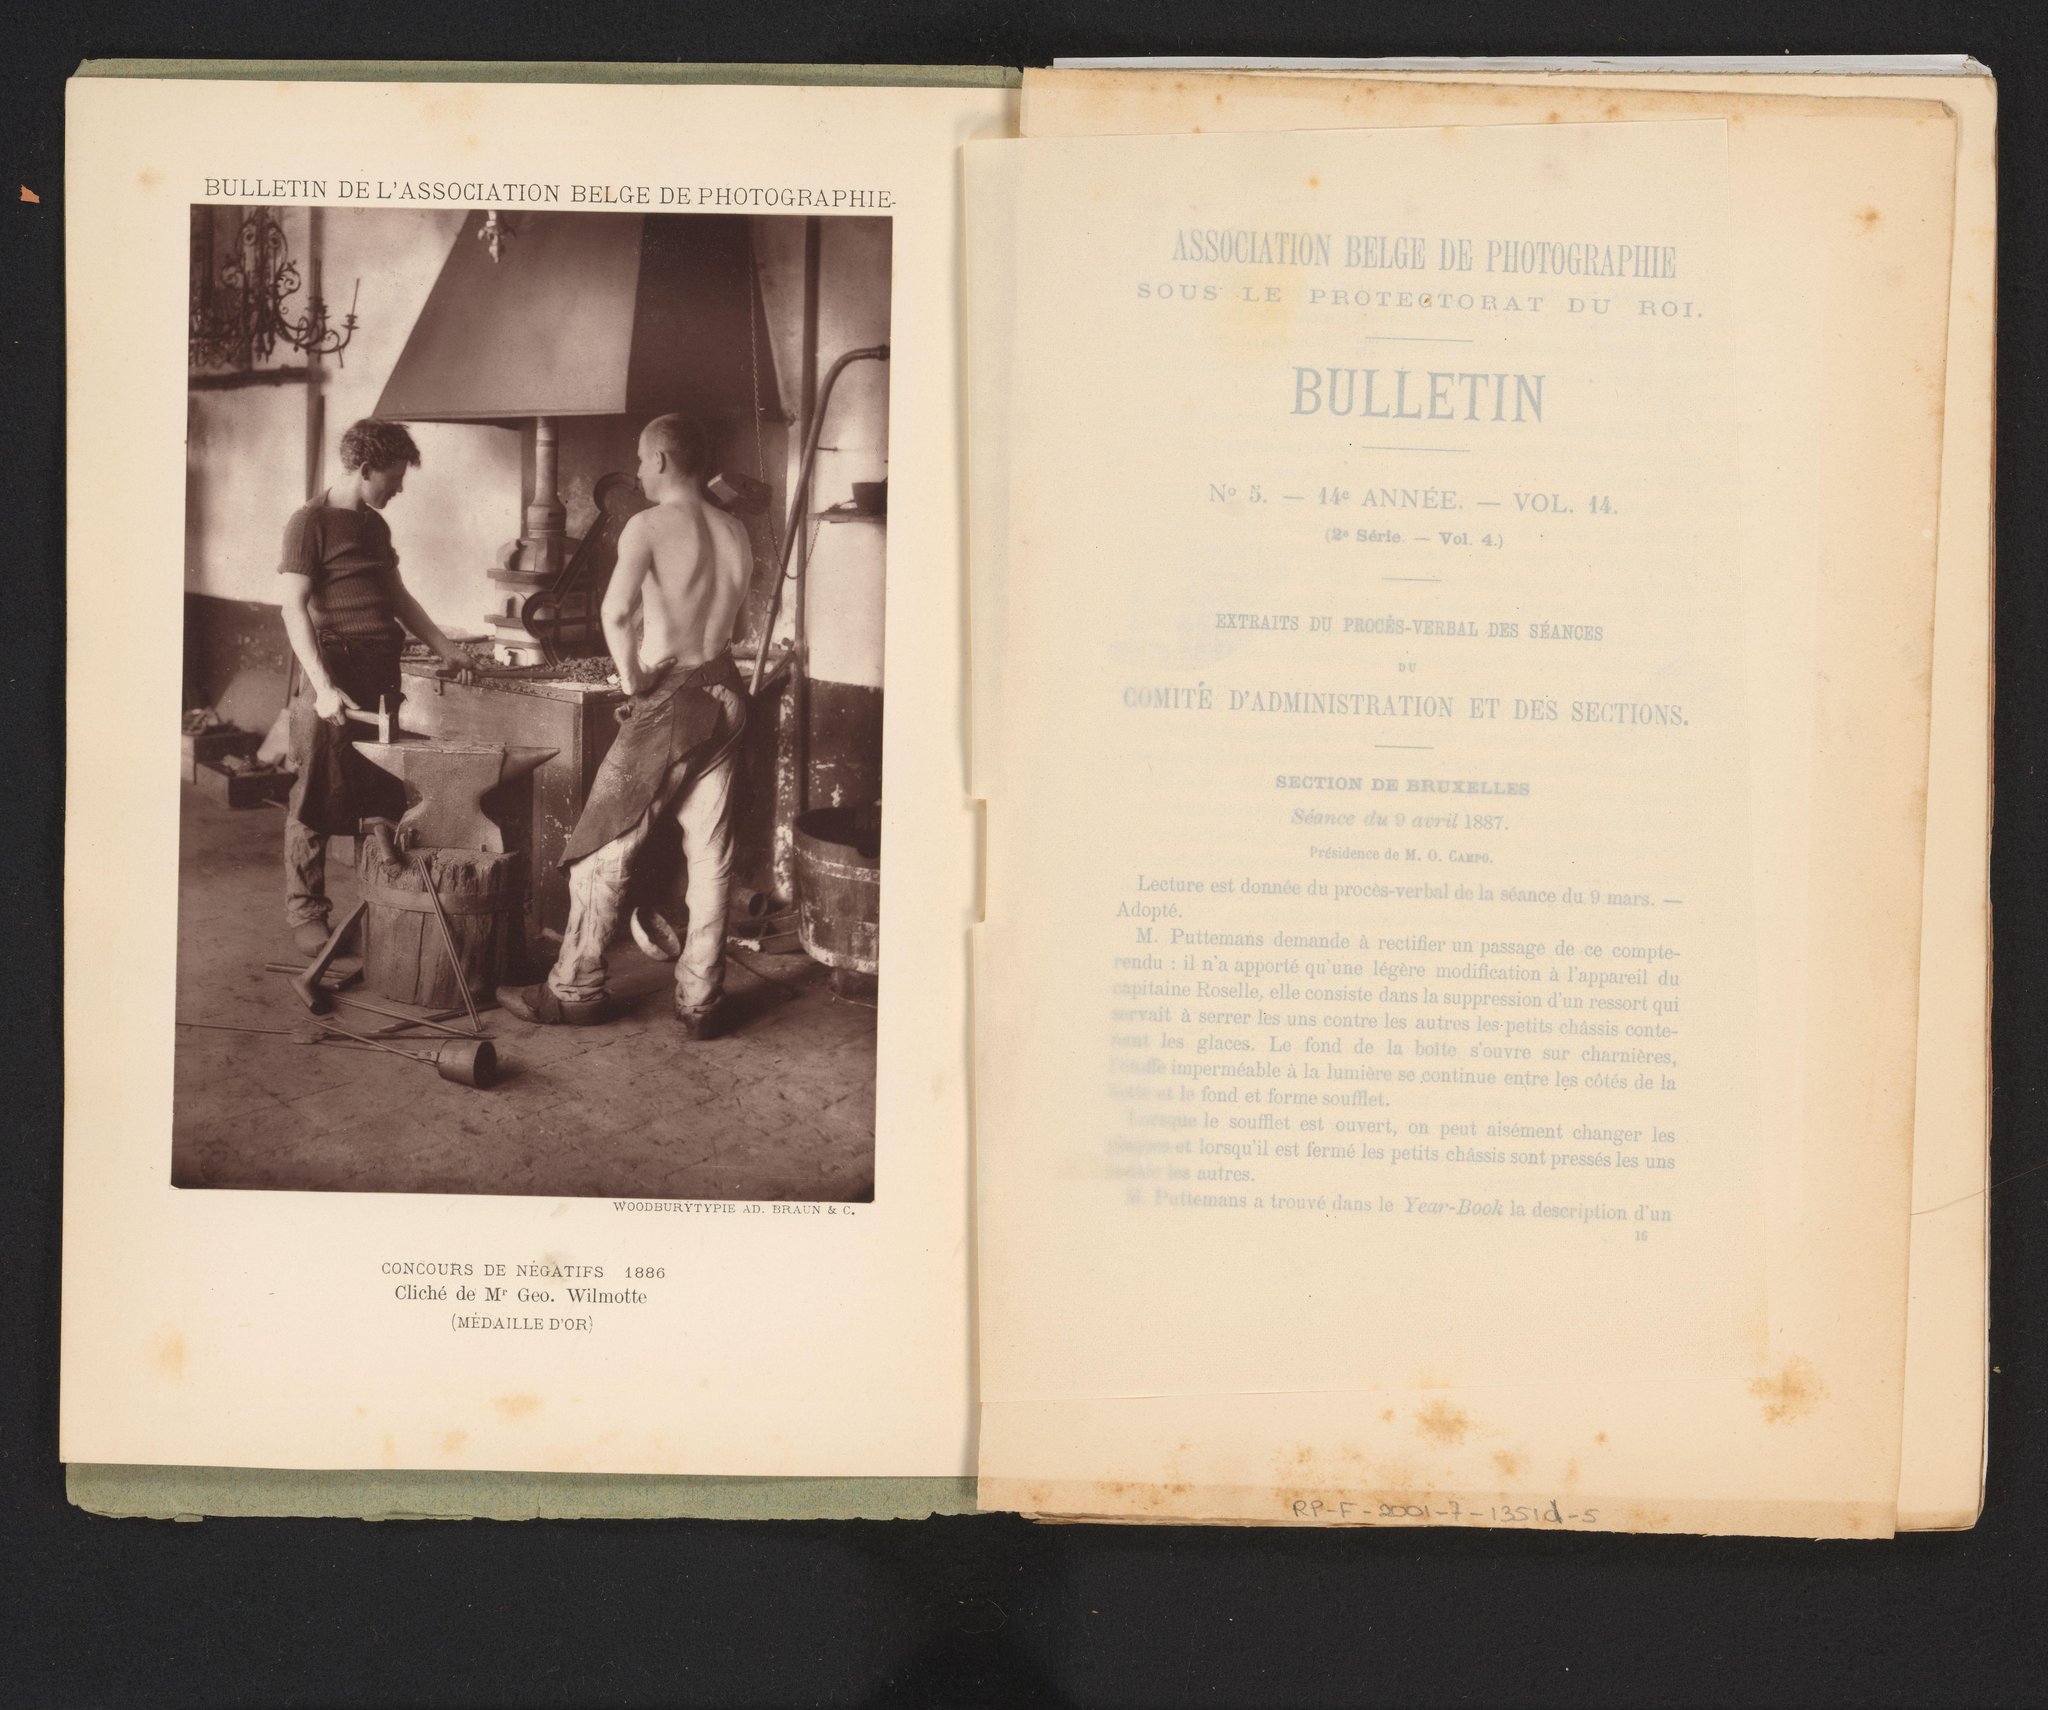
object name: page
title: Twee mannen aan het werk in een smidse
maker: Anonymous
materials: paper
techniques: woodburytype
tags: smith, blacksmith (+ men (labourers))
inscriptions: inscription: ‘CONCOURS DE NÉGATIFS 1886/ Cliché de Mr Geo. Wilmotte/ (MÉDAILLE D'OR)’, inscription: ‘BULLETIN DE L'ASSOCIATION BELGE DE PHOTOGRAPHIE’